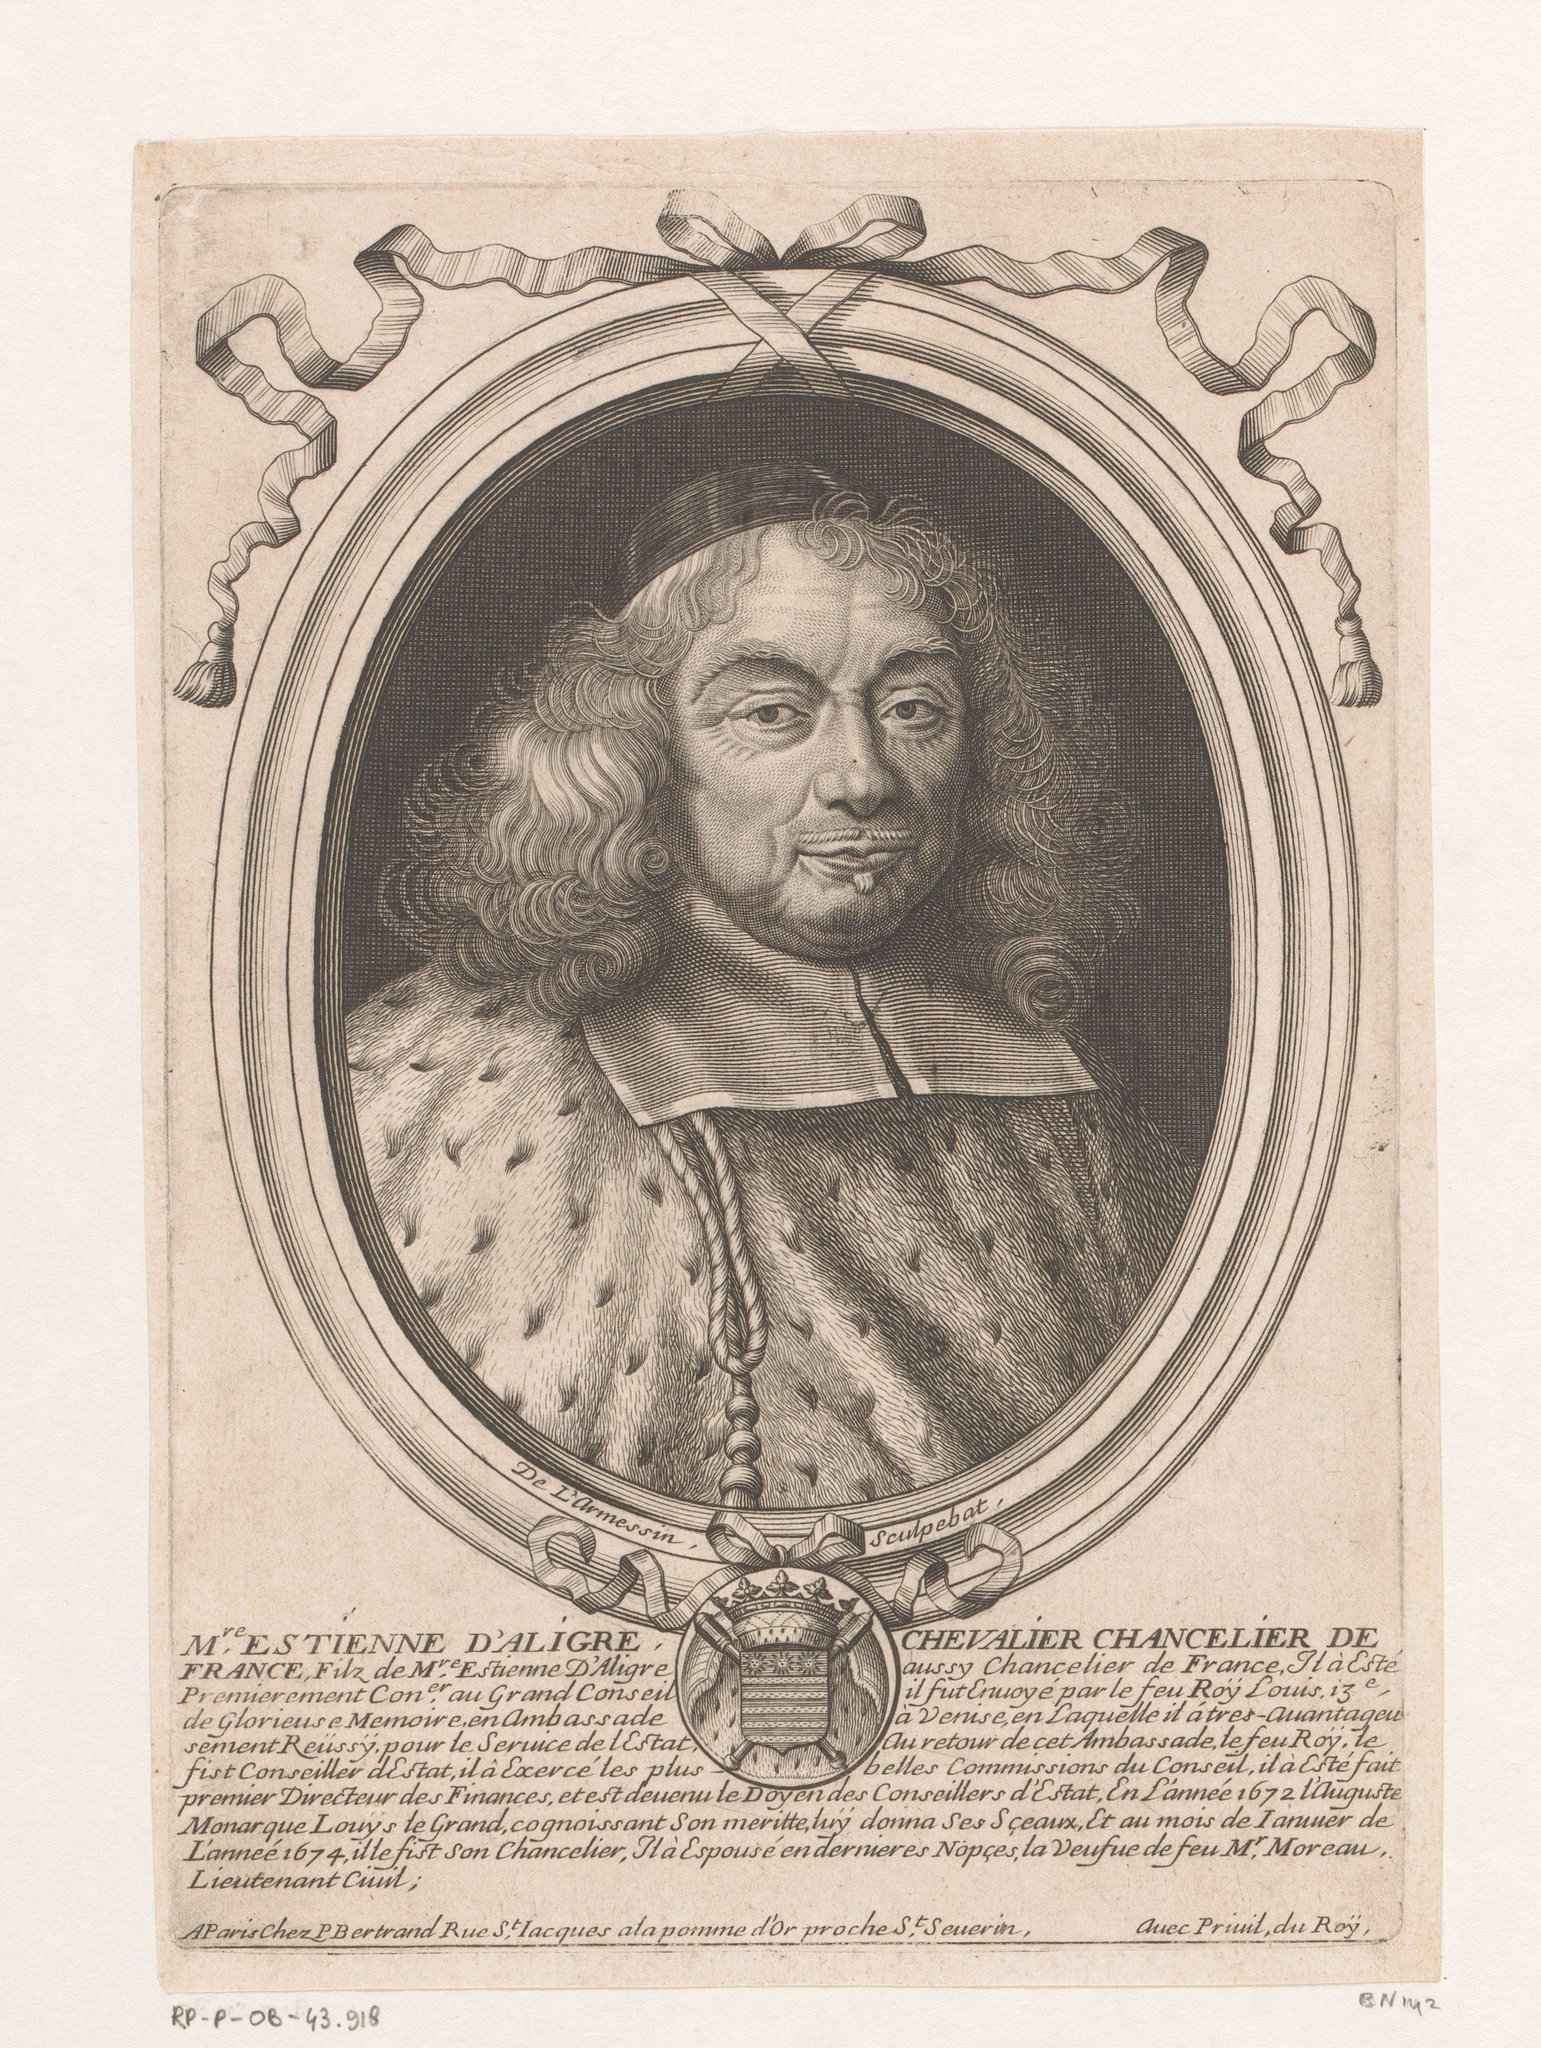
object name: print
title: Portret van Étienne (II) d'Aligre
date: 1642-1678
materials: paper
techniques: engraving, etching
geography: france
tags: politician, historical persons, politician, e.g. party leader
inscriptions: collector's mark: Lugt 2228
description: Maakt deel uit van een grootschalige serie met portretten van prominente figuren. Binnen de serie bevindt zich een sectie getiteld 'Les Augustes Représentations De tous les Roys De France depuis Pharamond Iusqu'à Louys XIIII'. De serie werd respectievelijk uitgegeven door Pierre Bertrand, door zijn weduwe en door De Larmessin zelf.